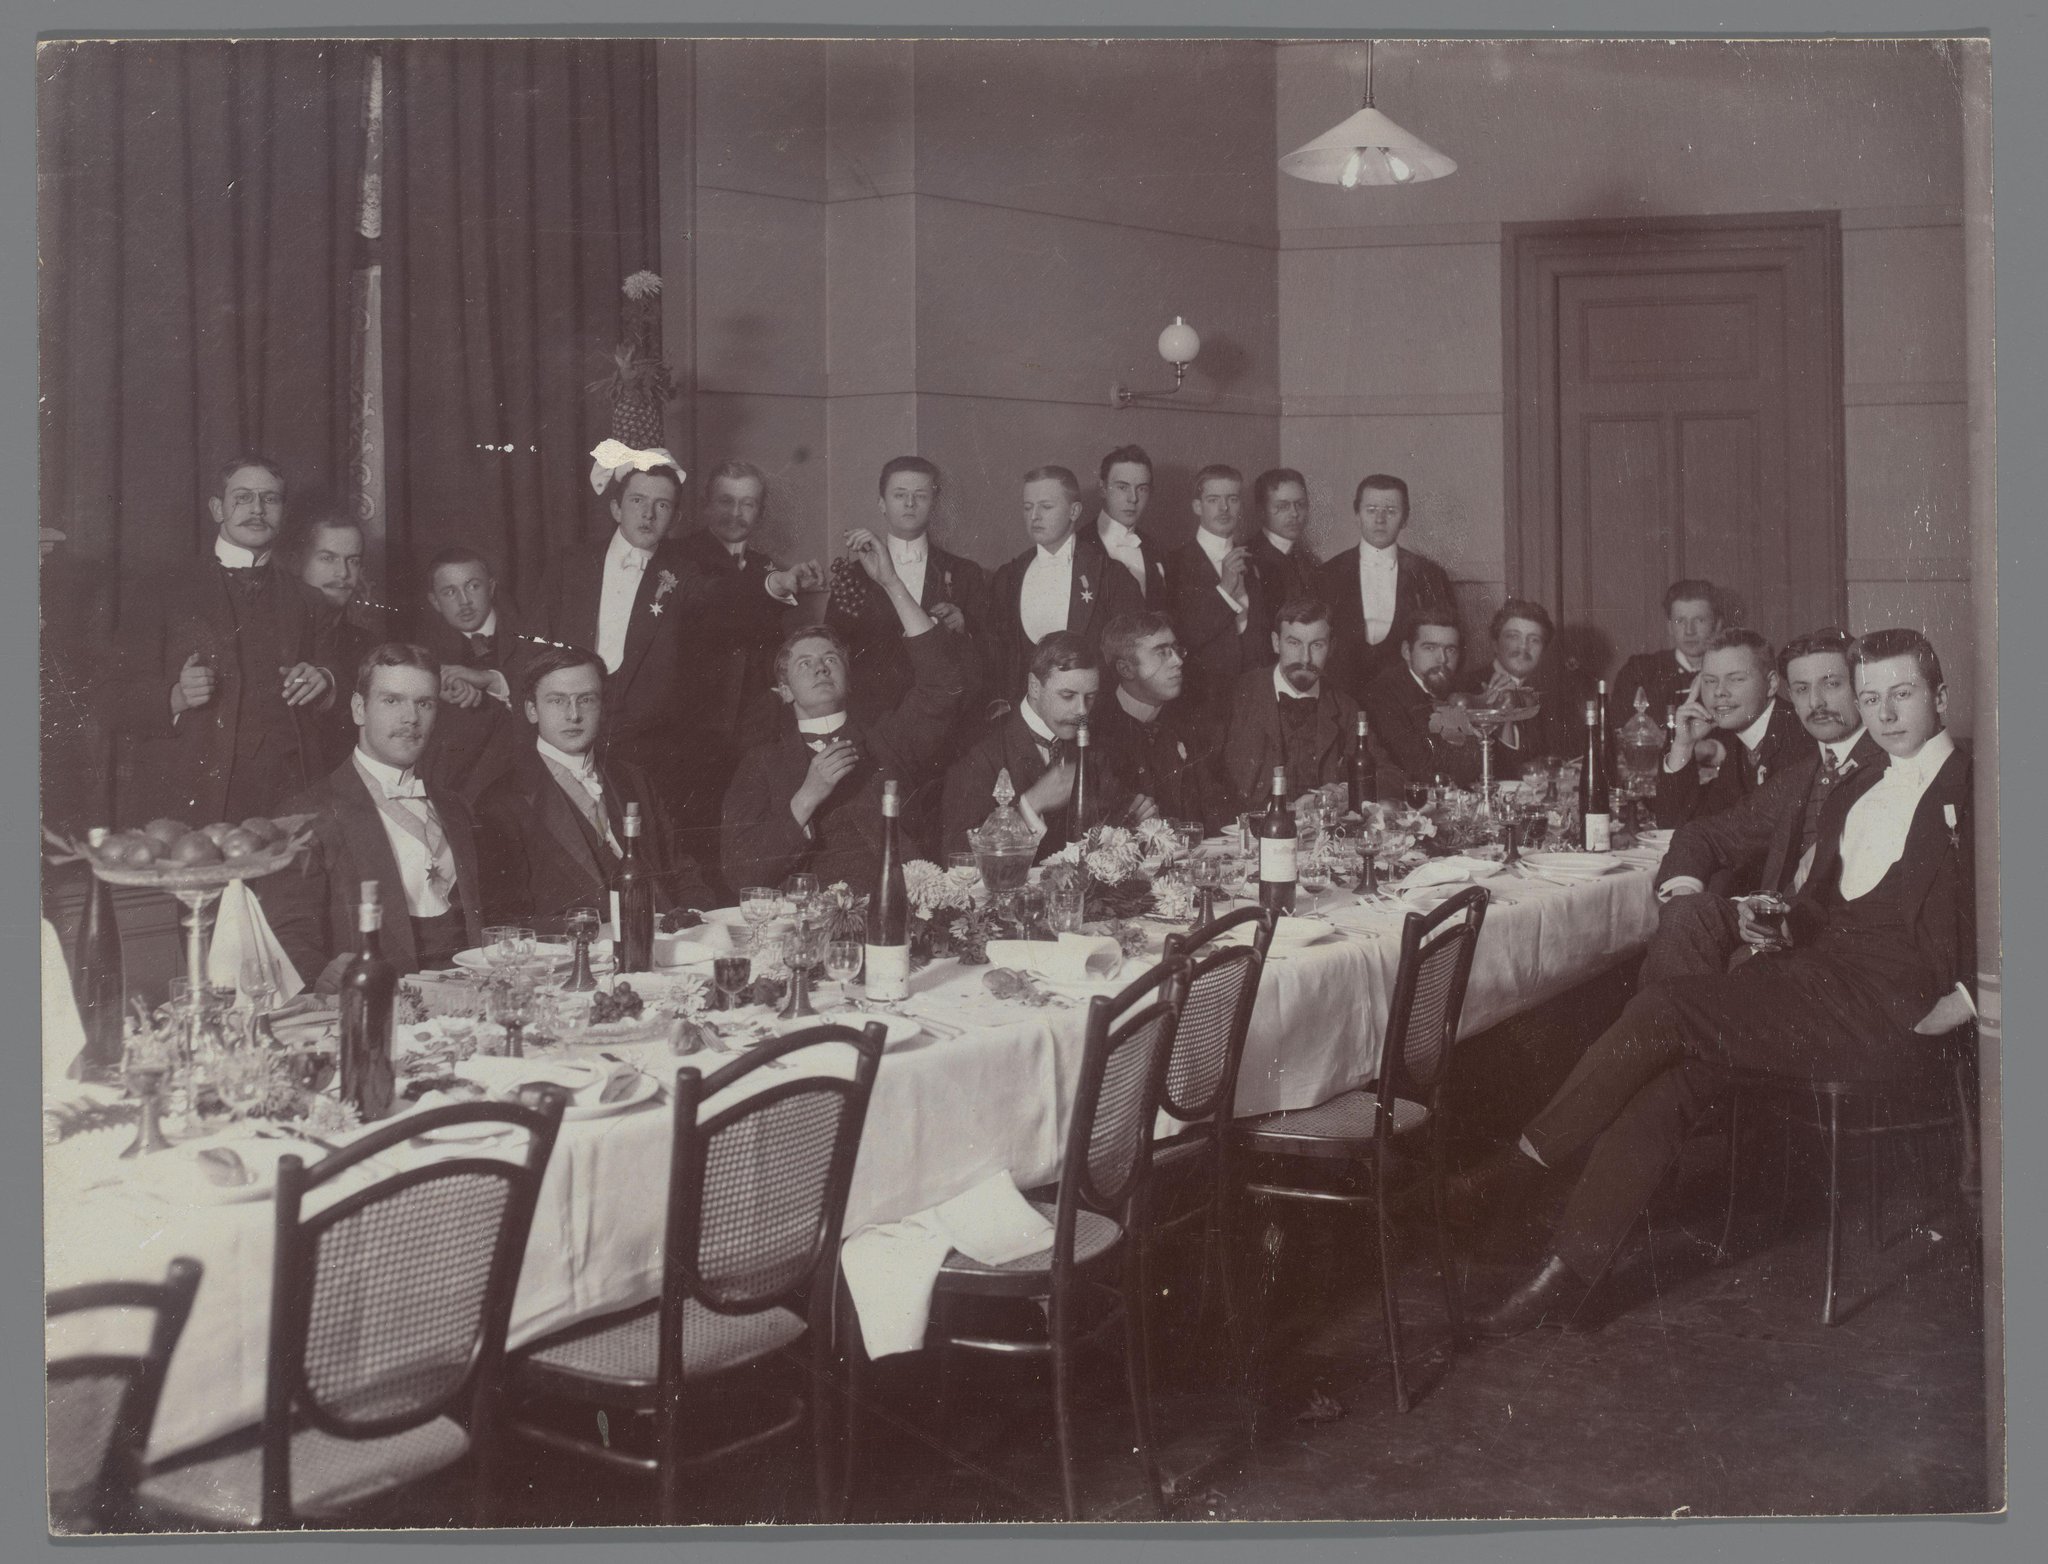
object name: photograph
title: Inauguratie na brood van Clio op zaterdag 25 november 1905 in Parkzicht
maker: Anonymous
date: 1905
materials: photographic support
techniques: collodion silver print